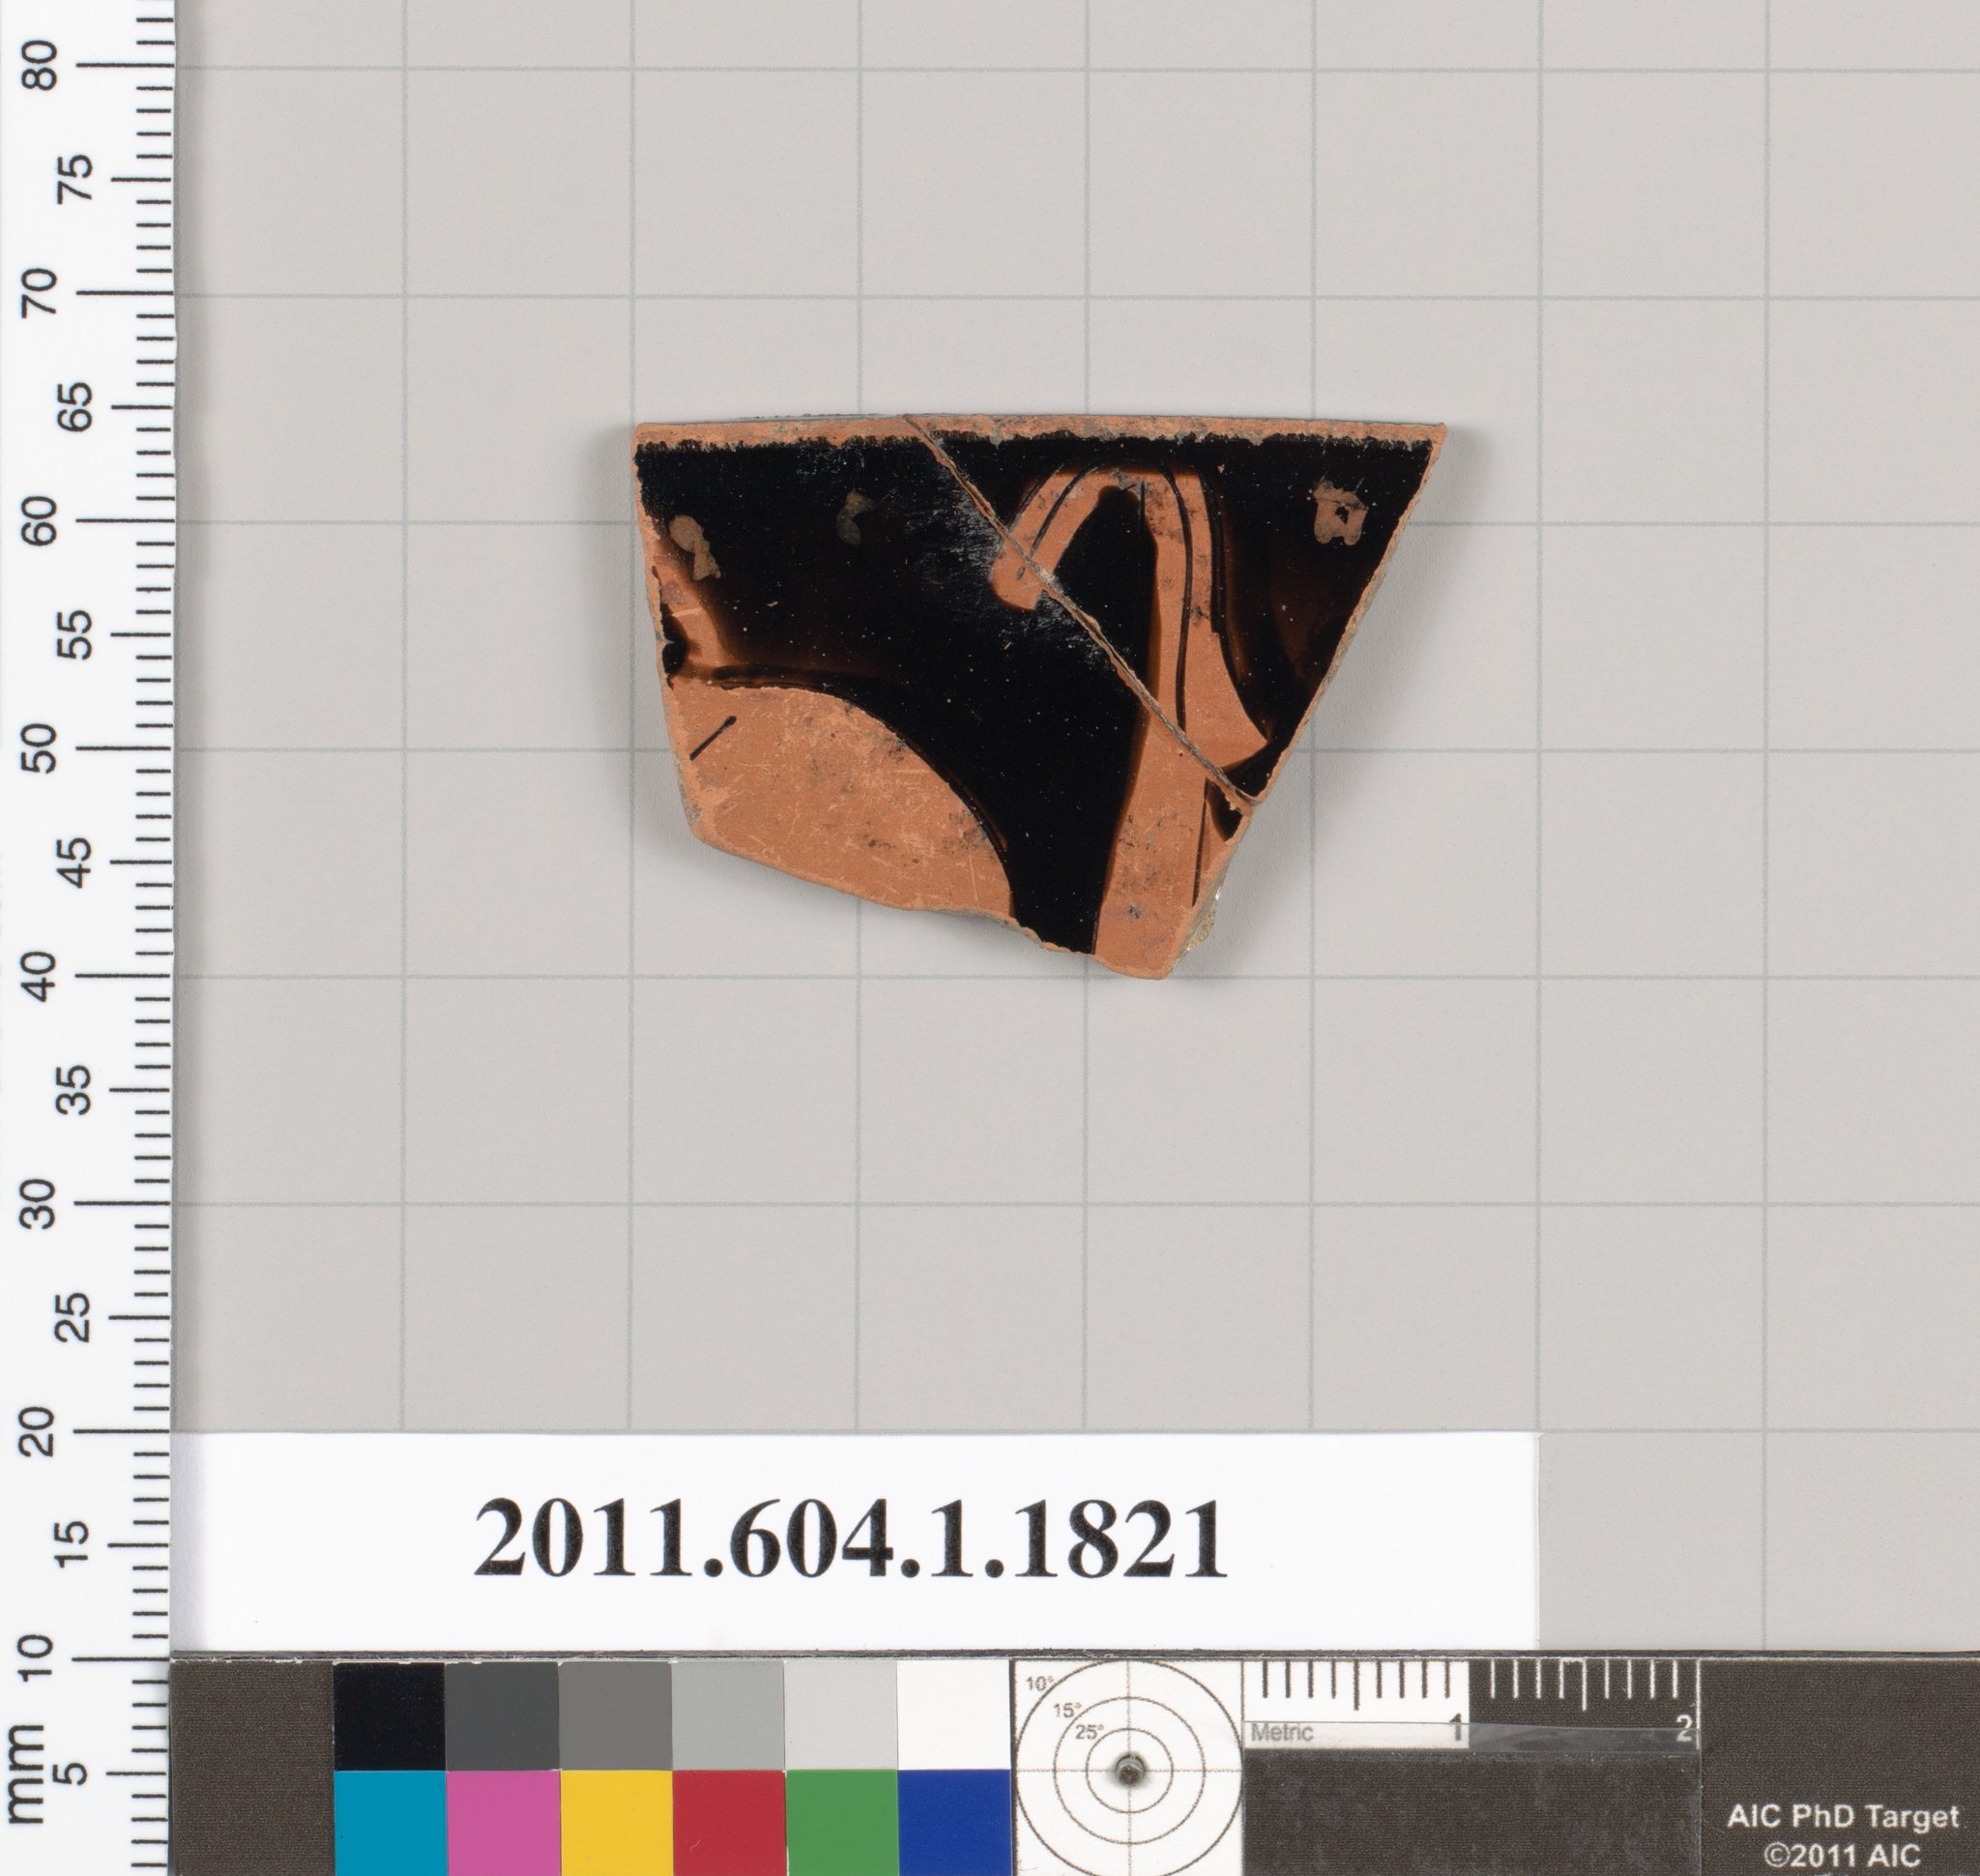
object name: kylix fragment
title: Terracotta rim fragment of a kylix (drinking cup)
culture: greek, attic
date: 500-476 BCE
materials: terracotta